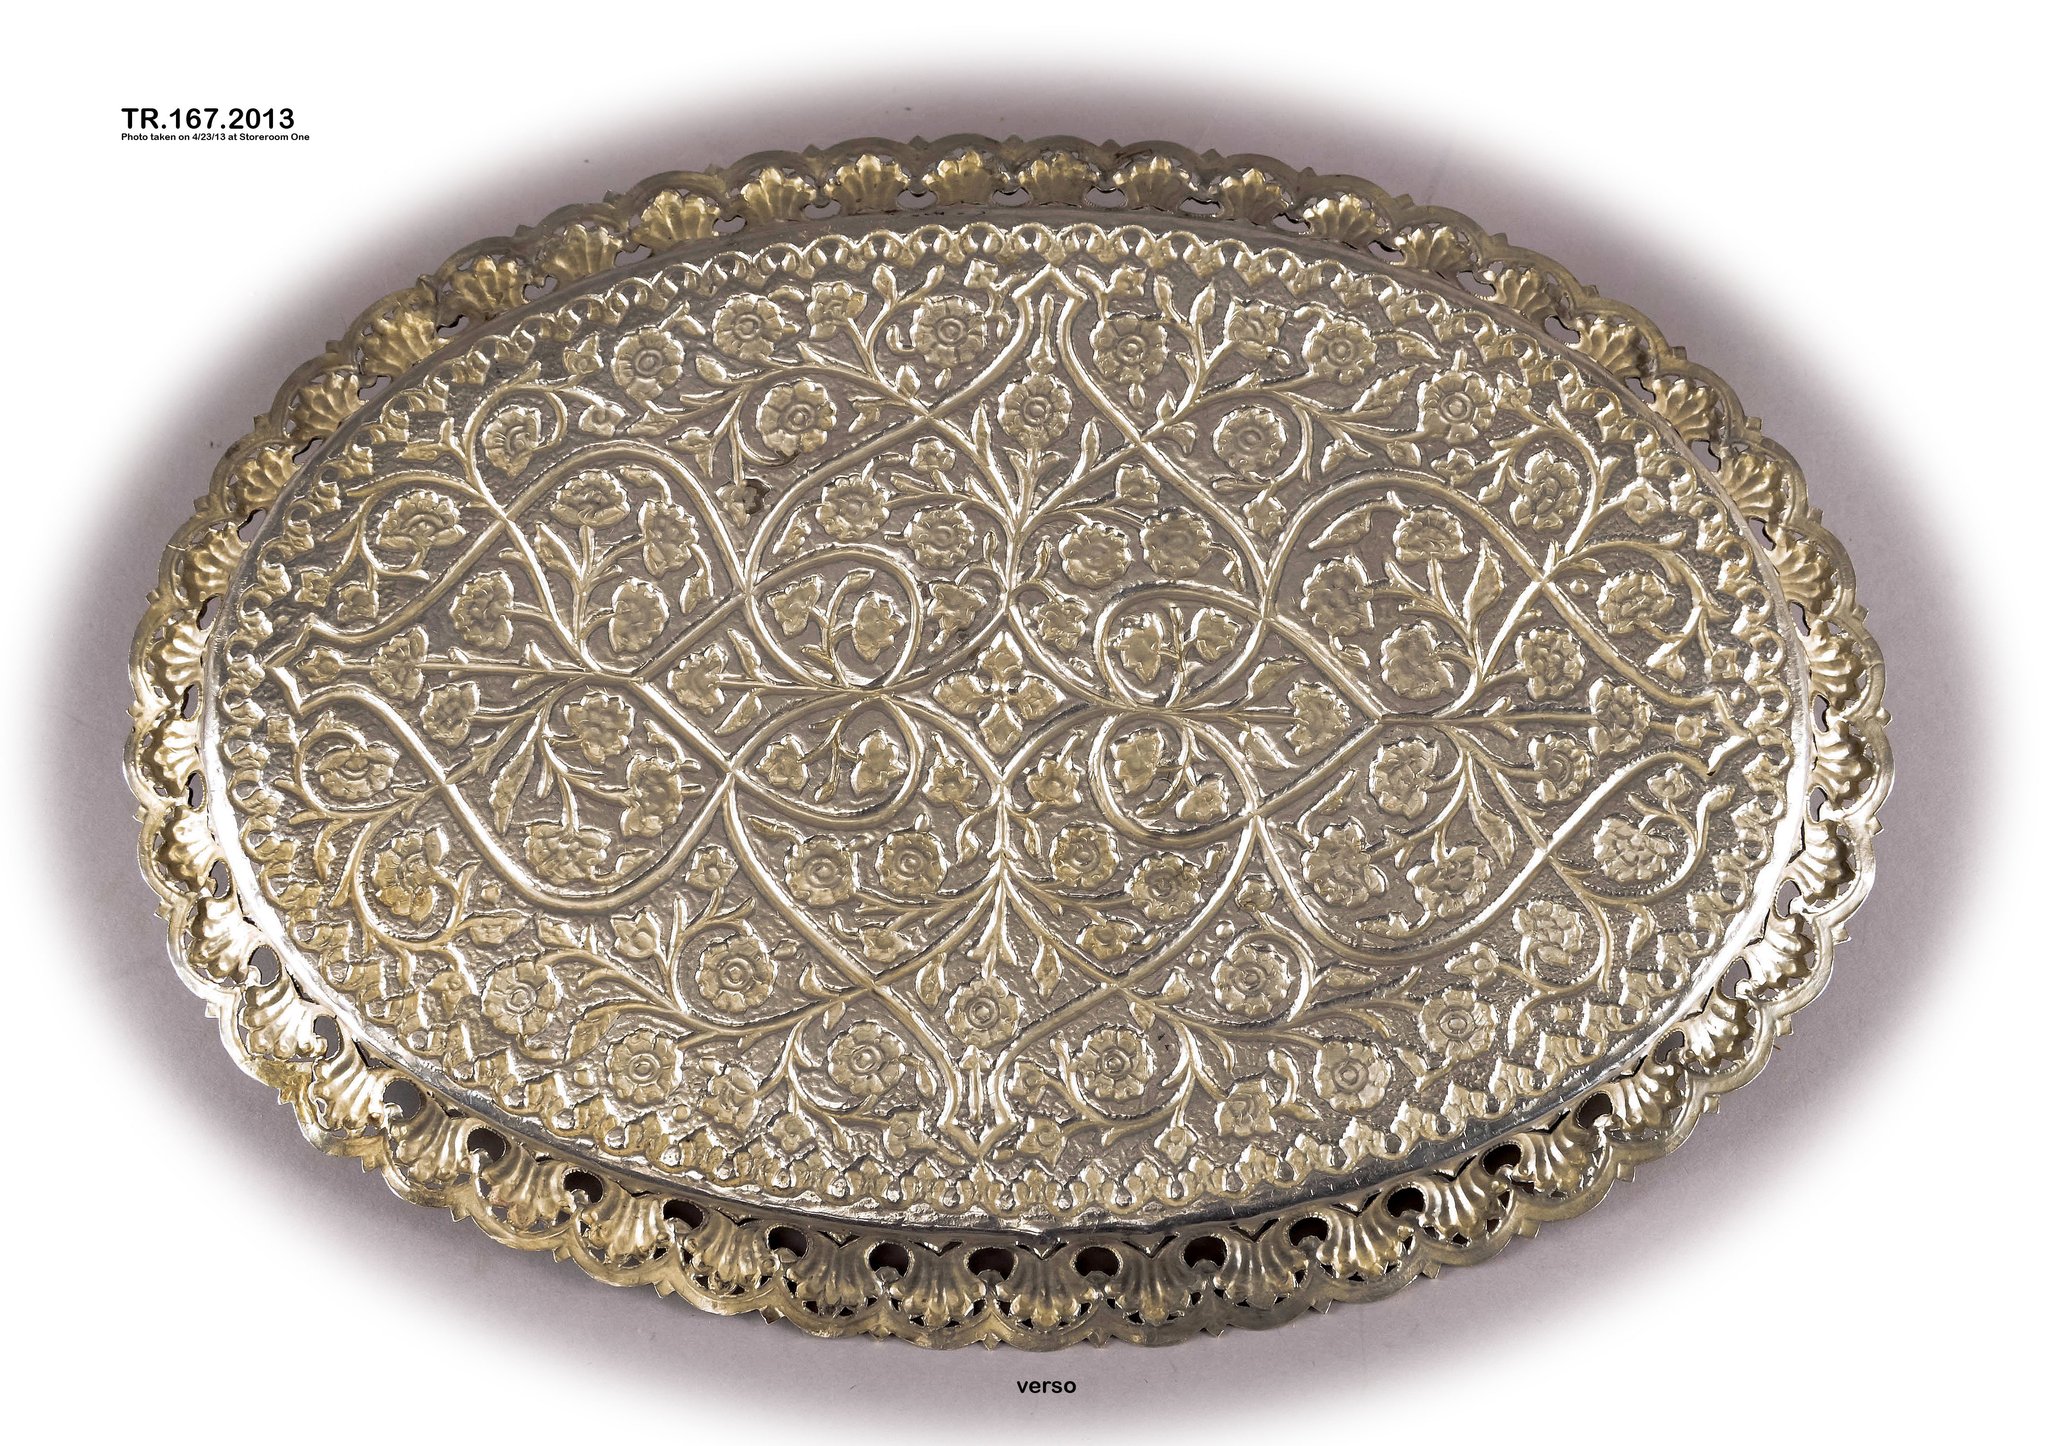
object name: tray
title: Silver Gilt Tray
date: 1767-1800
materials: silver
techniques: gilding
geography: india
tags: flowers